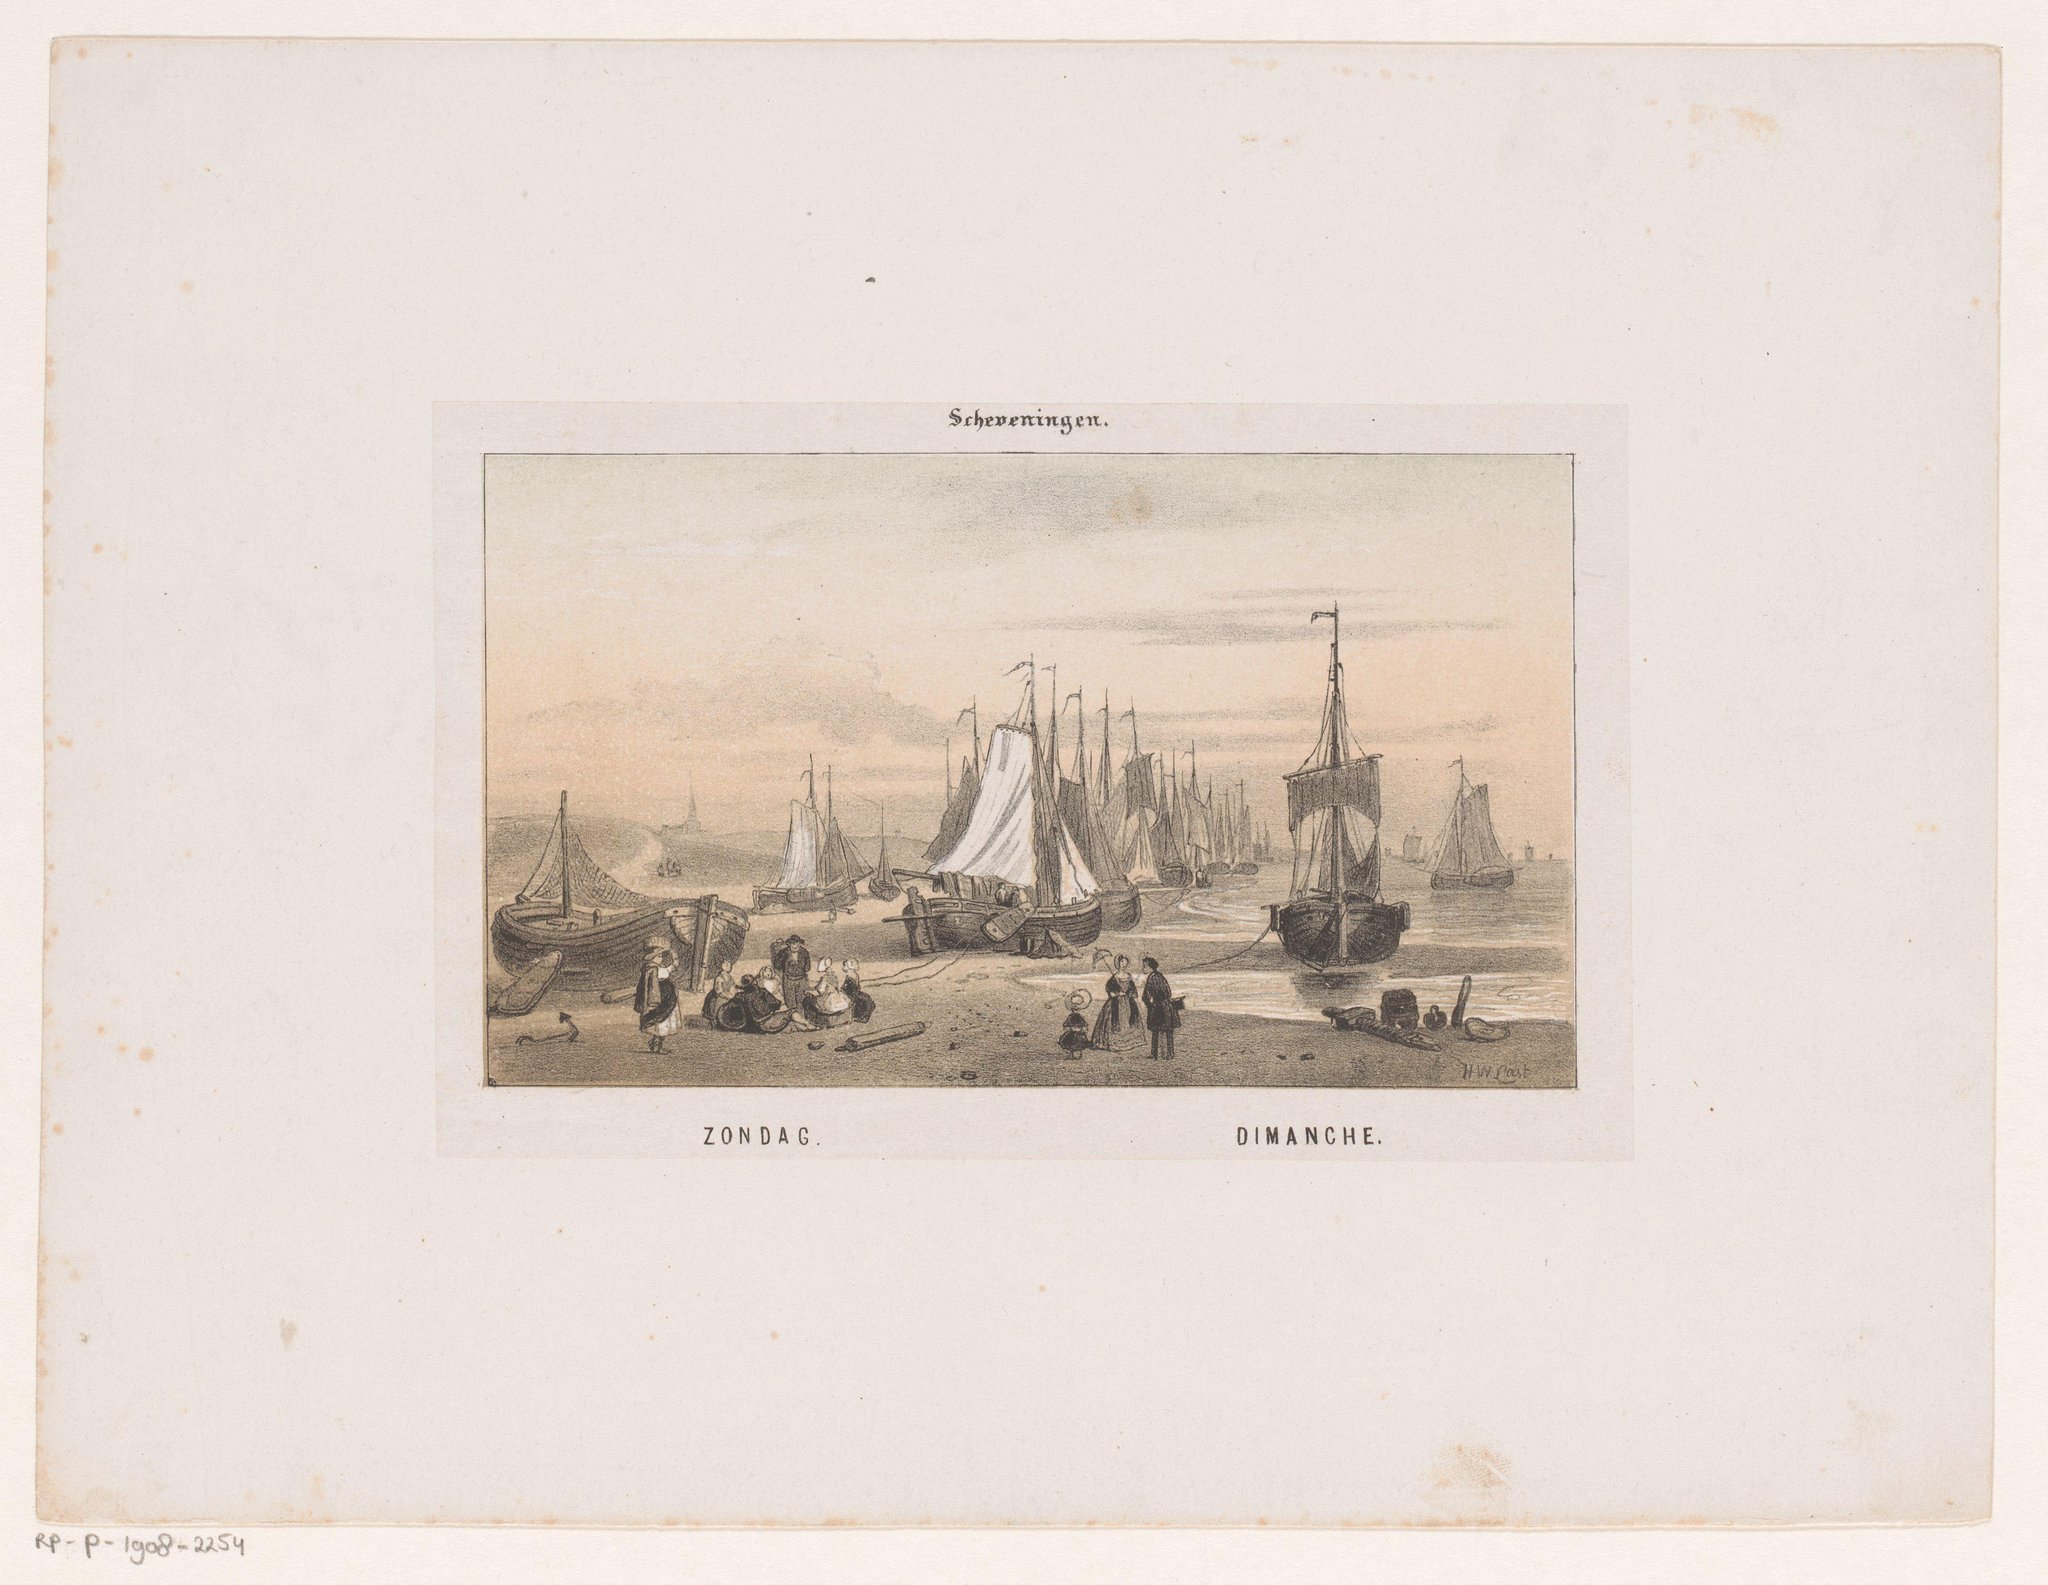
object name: print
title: Boten op het strand van Scheveningen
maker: hendrik wilhelmus last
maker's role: print maker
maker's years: 1817-1873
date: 1827-1873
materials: paper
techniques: iris print, lithograph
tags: ships, boats on land, beached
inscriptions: collector's mark: Lugt 2228